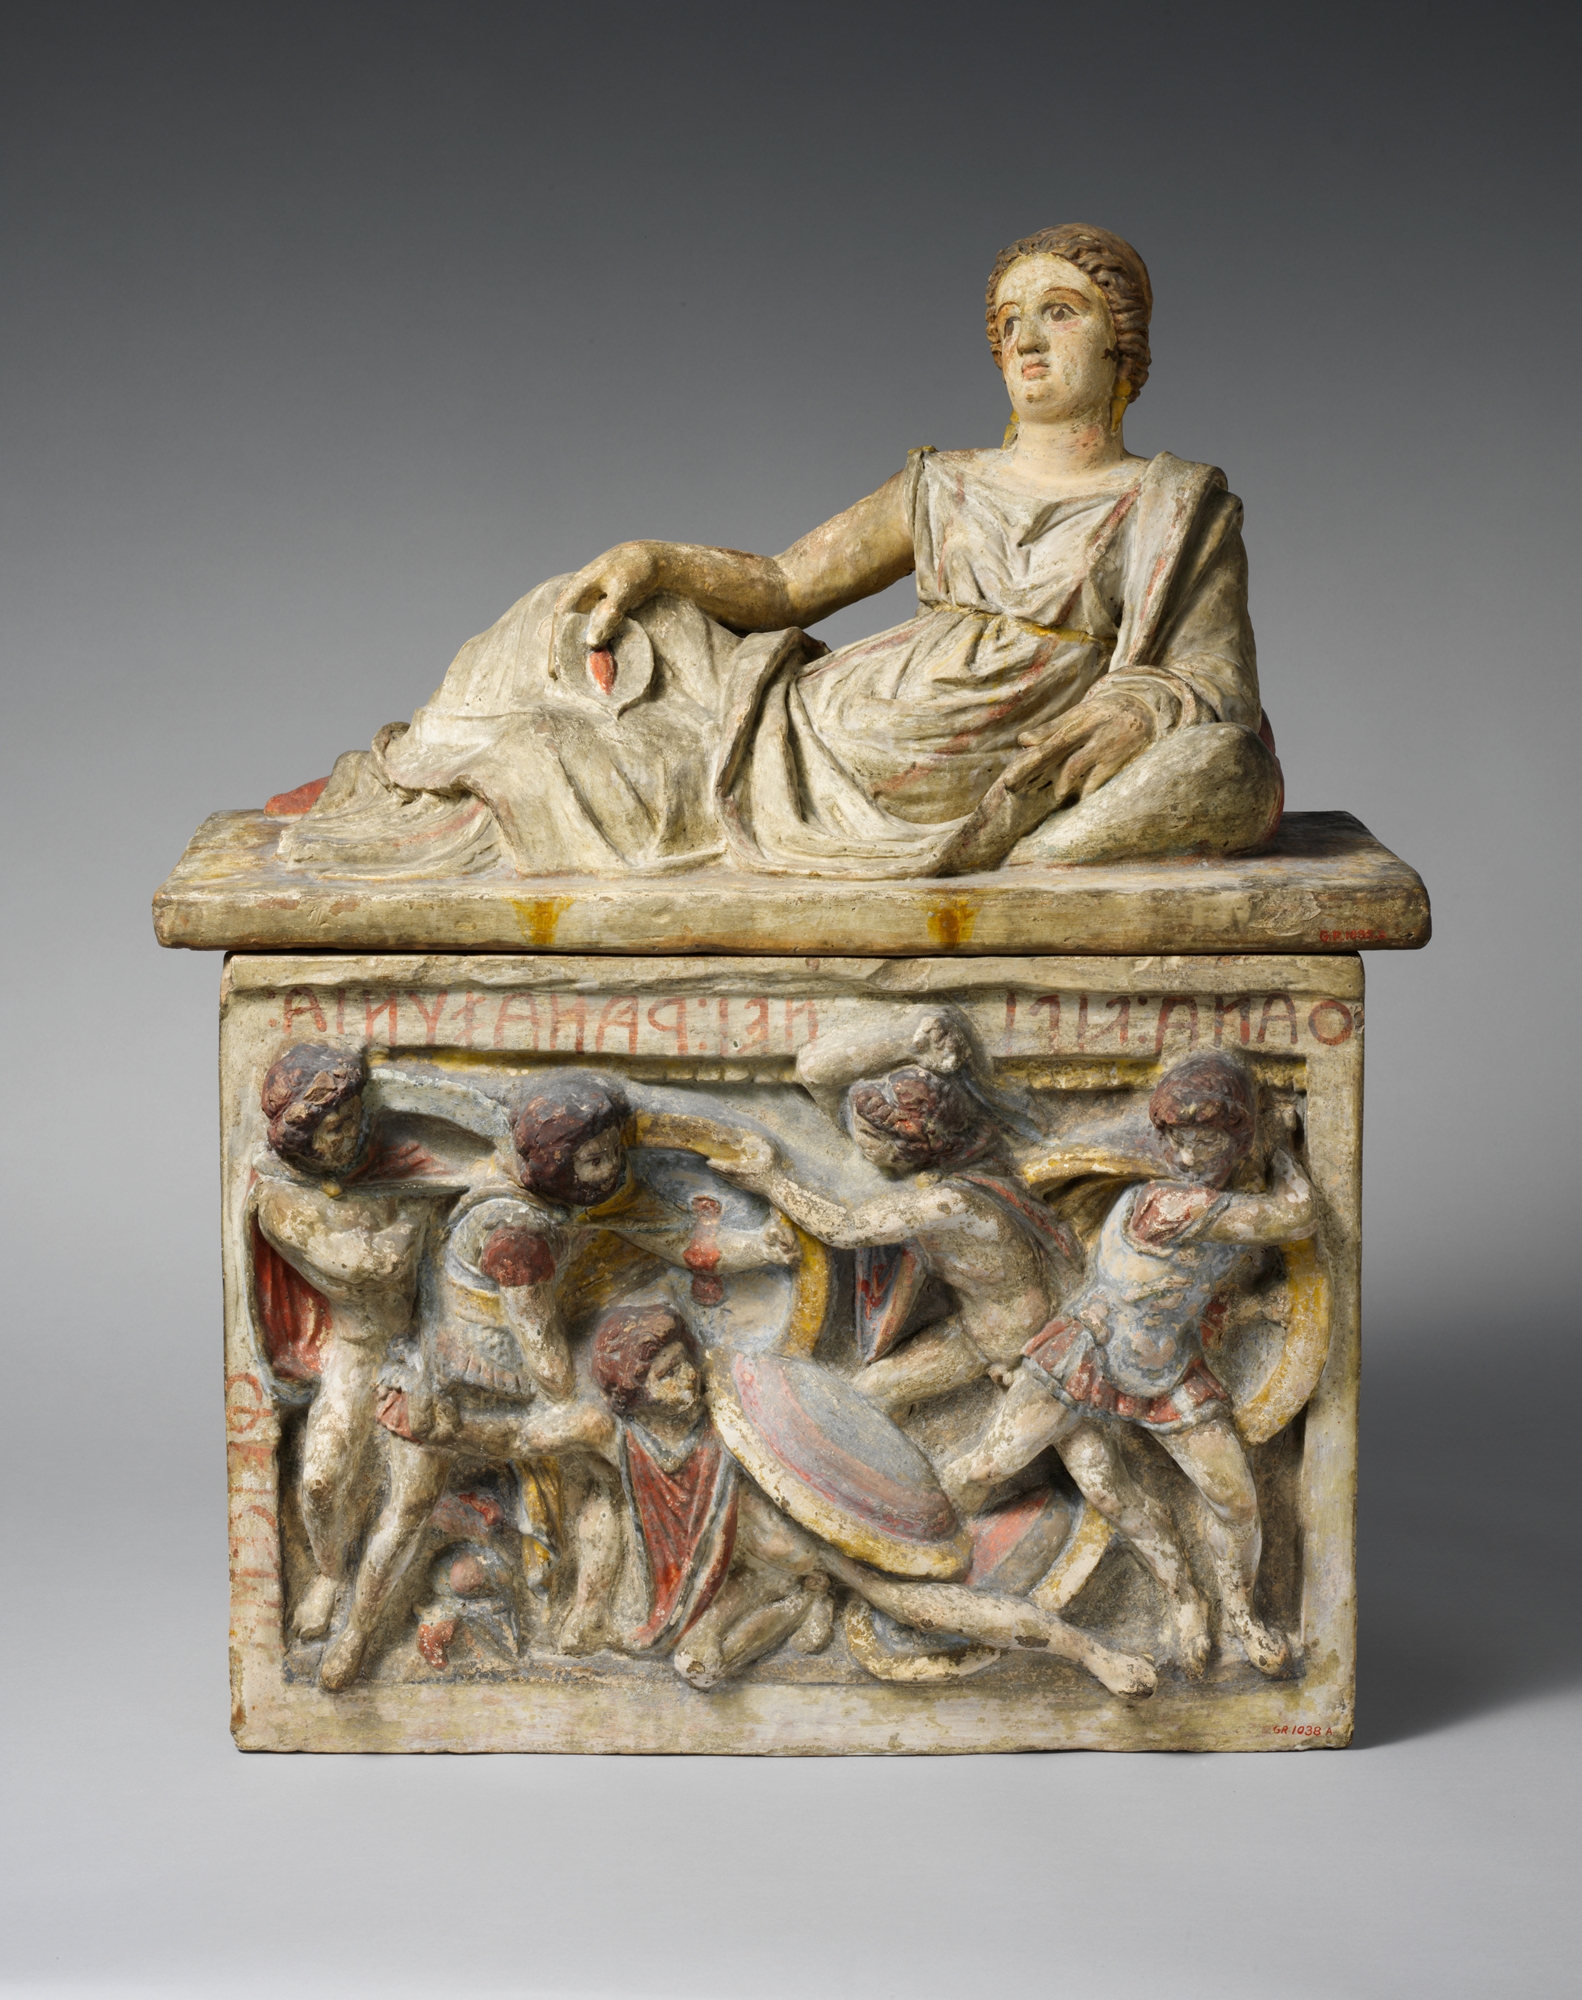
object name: cinerary urn with lid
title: Terracotta cinerary urn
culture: etruscan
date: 200-101 BCE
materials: terracotta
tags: battles,soldiers,women